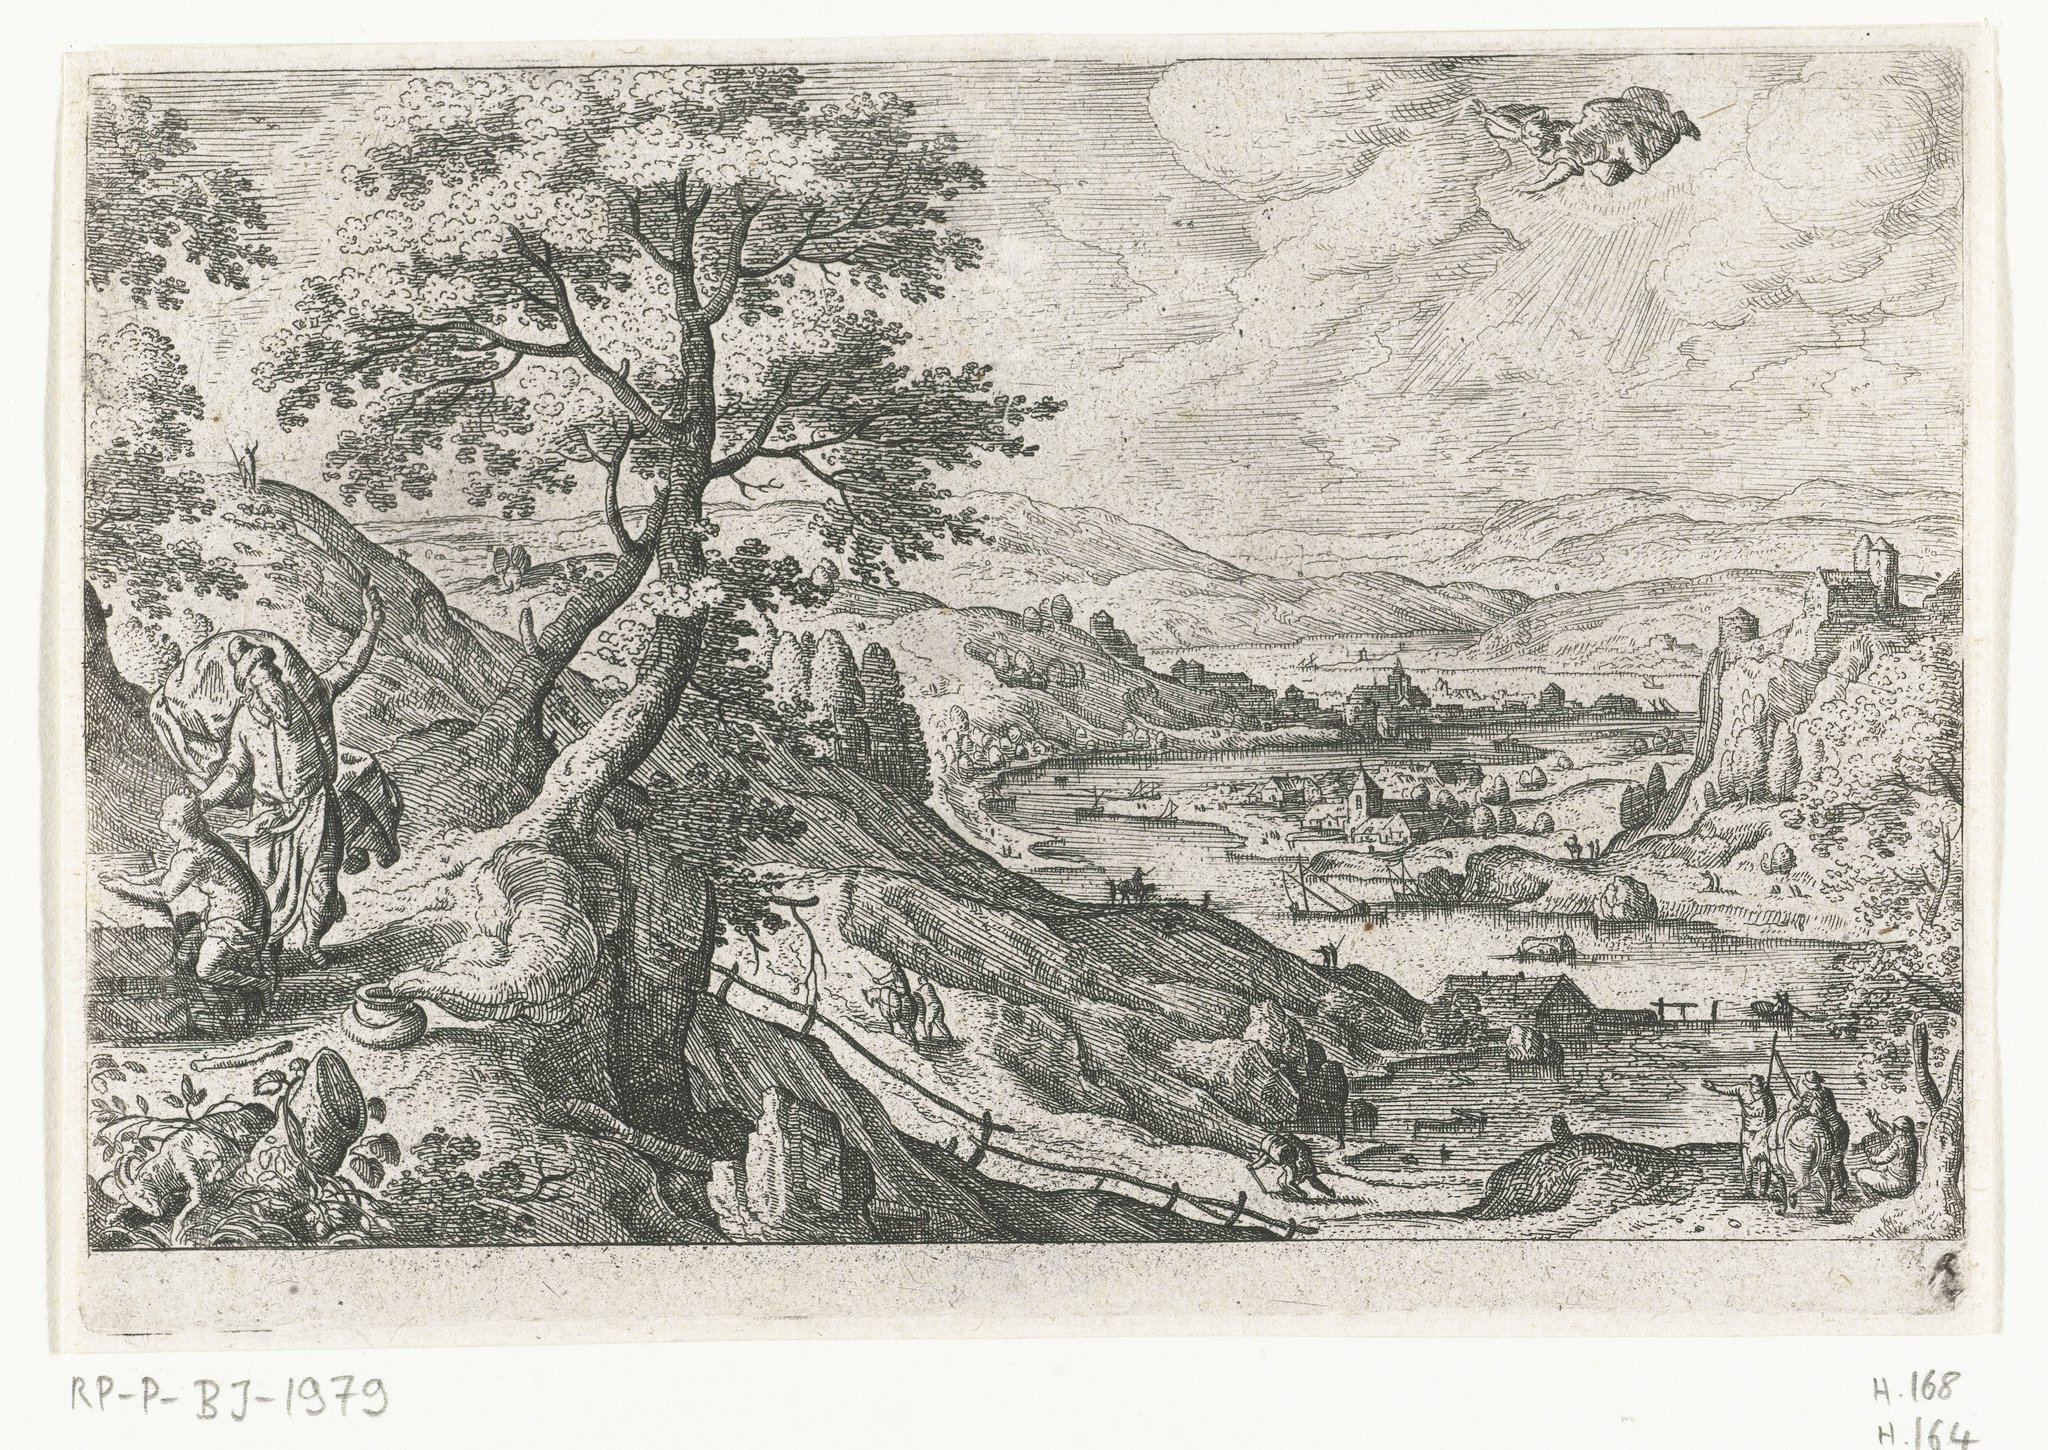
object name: print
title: Landschappen met mythologische en bijbelse voorstellingen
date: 1550-1650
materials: paper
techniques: etching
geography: southern netherlands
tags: when abraham has his hand raised to kill isaac, an angel restrains abraham's hand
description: Abraham staat op het punt om zijn zoon Isaak te offeren. Een engel houdt hem tegen en Abraham offert in plaats van Isaak een ram die zich links voor in een struik heeft verstrikt.